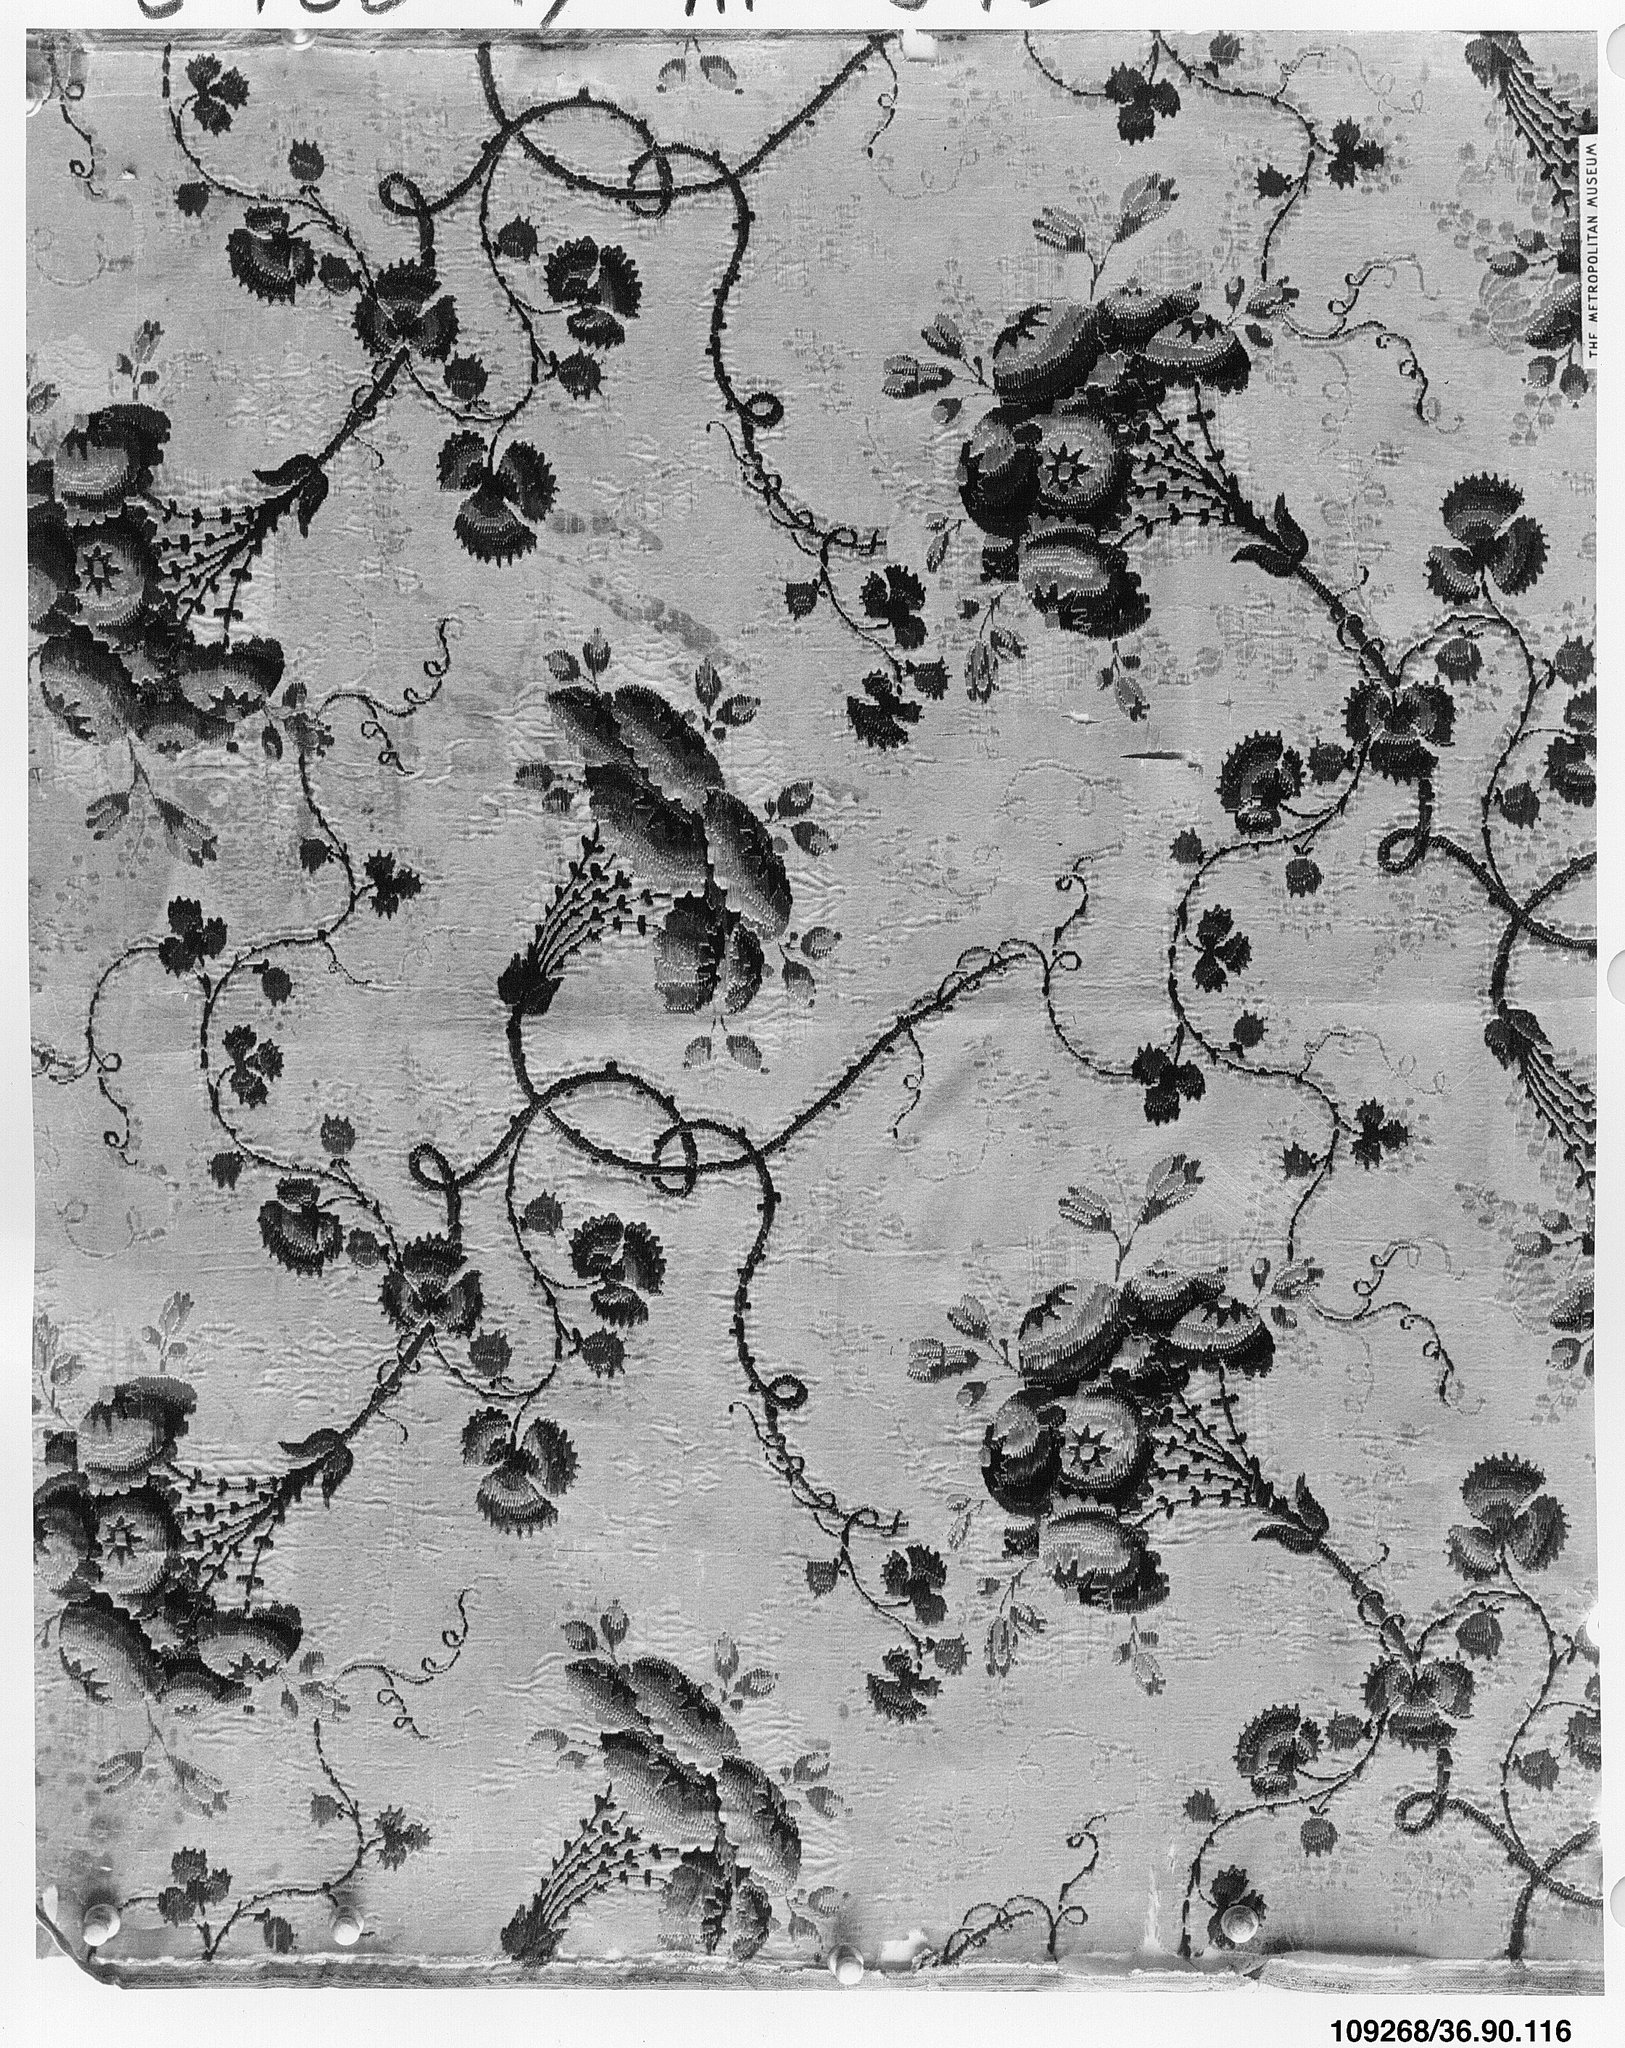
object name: piece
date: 1750-1760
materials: silk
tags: flowers,leaves